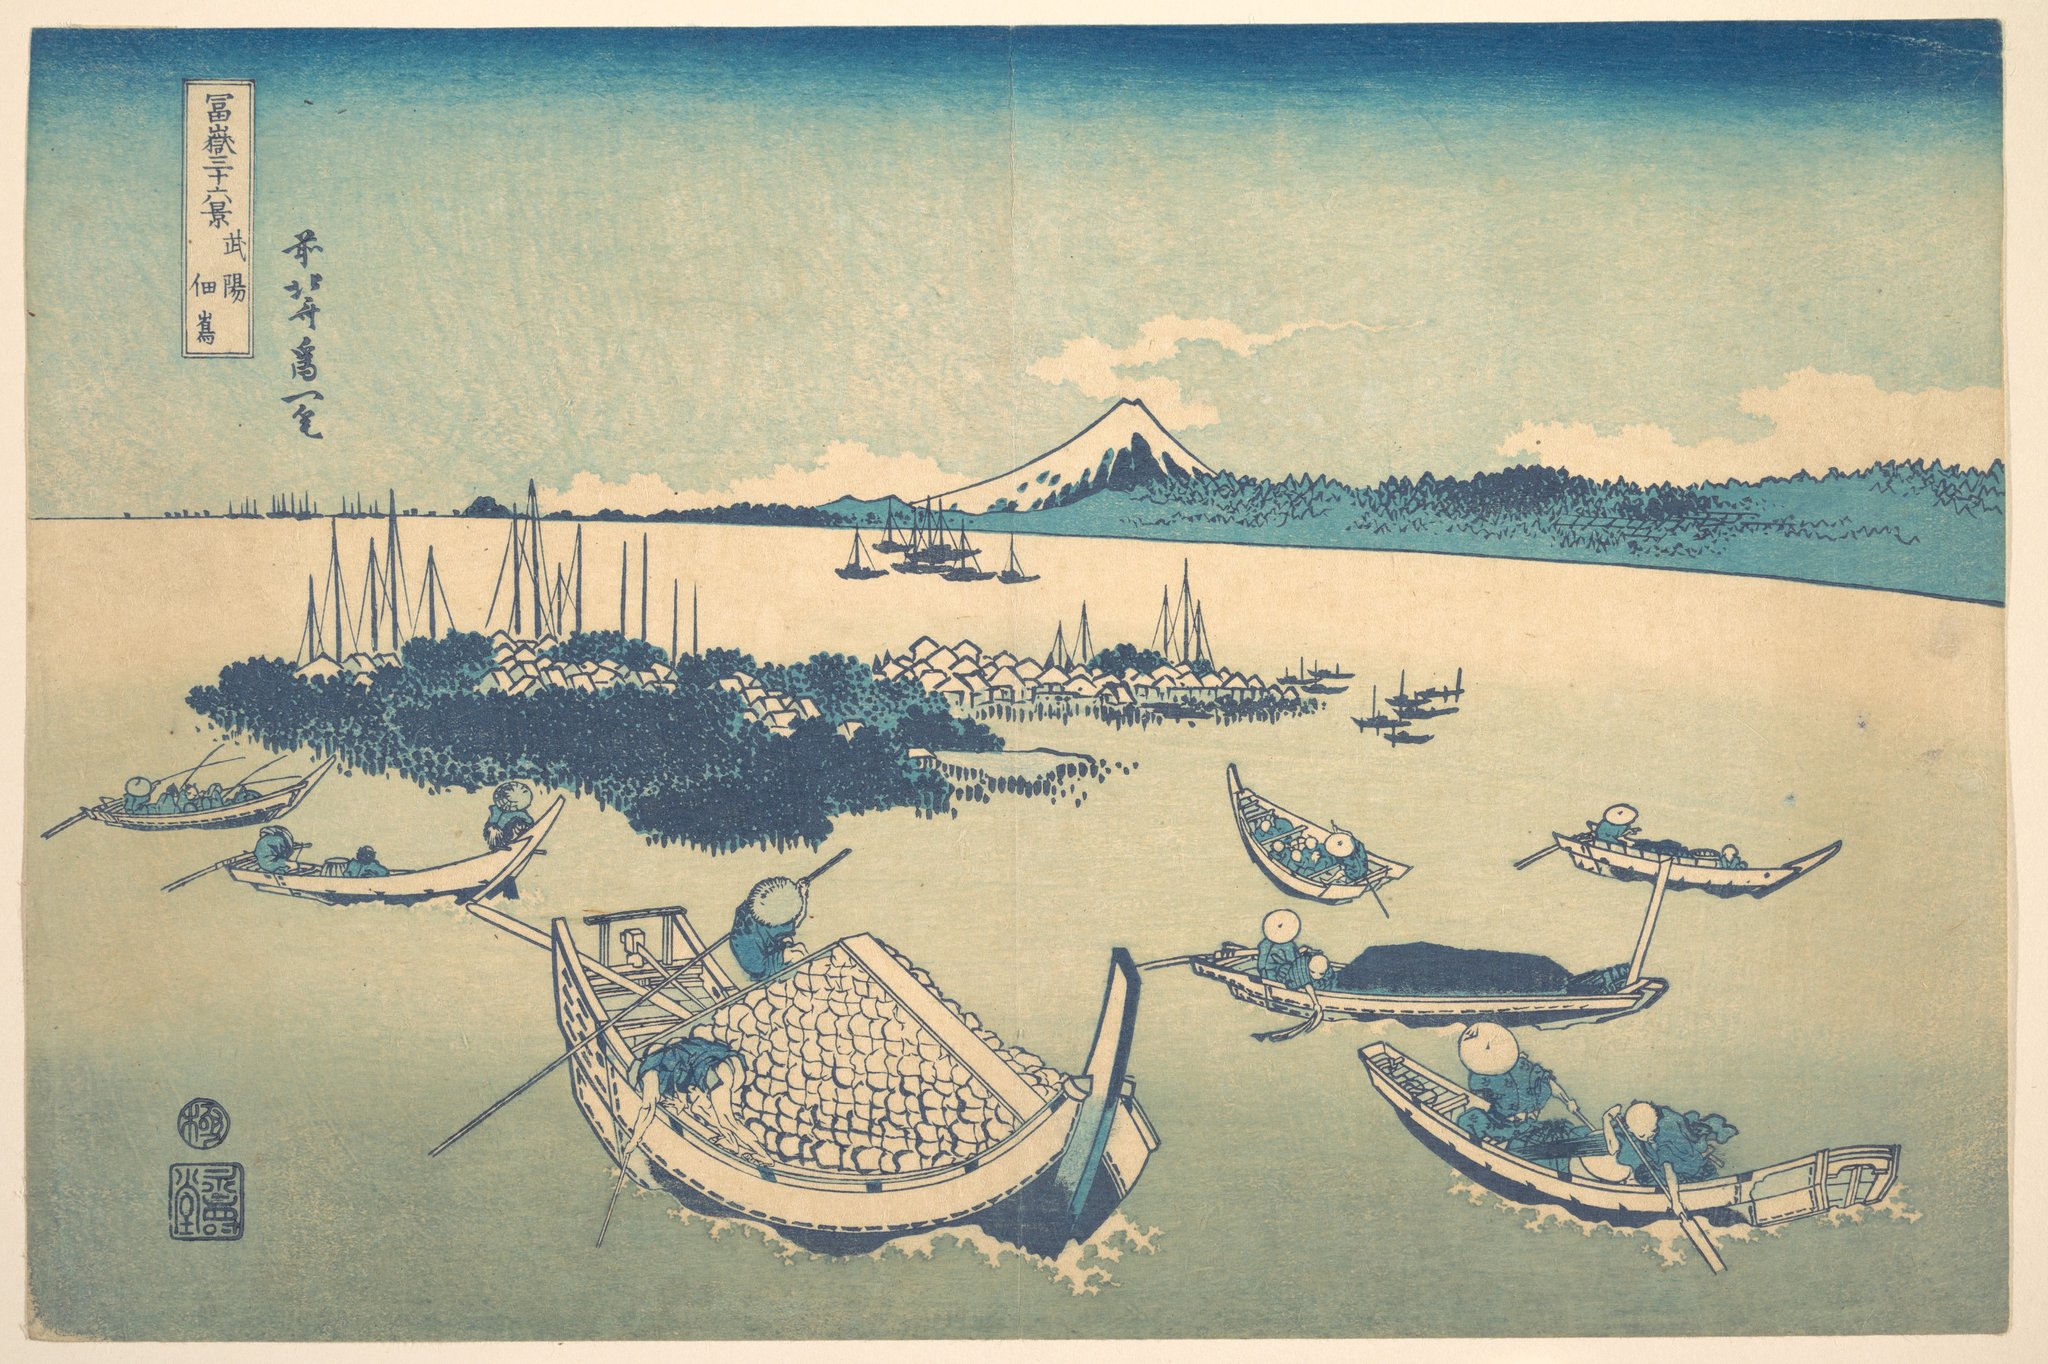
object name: woodblock print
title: Tsukudajima in Musashi Province (Buyō Tsukudajima), from the series Thirty-six Views of Mount Fuji (Fugaku sanjūrokkei)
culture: japanese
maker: katsushika hokusai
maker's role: artist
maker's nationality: japanese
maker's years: 1760-1849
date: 1830-1832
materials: ink, paper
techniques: woodblock print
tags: rivers,mountains,boats